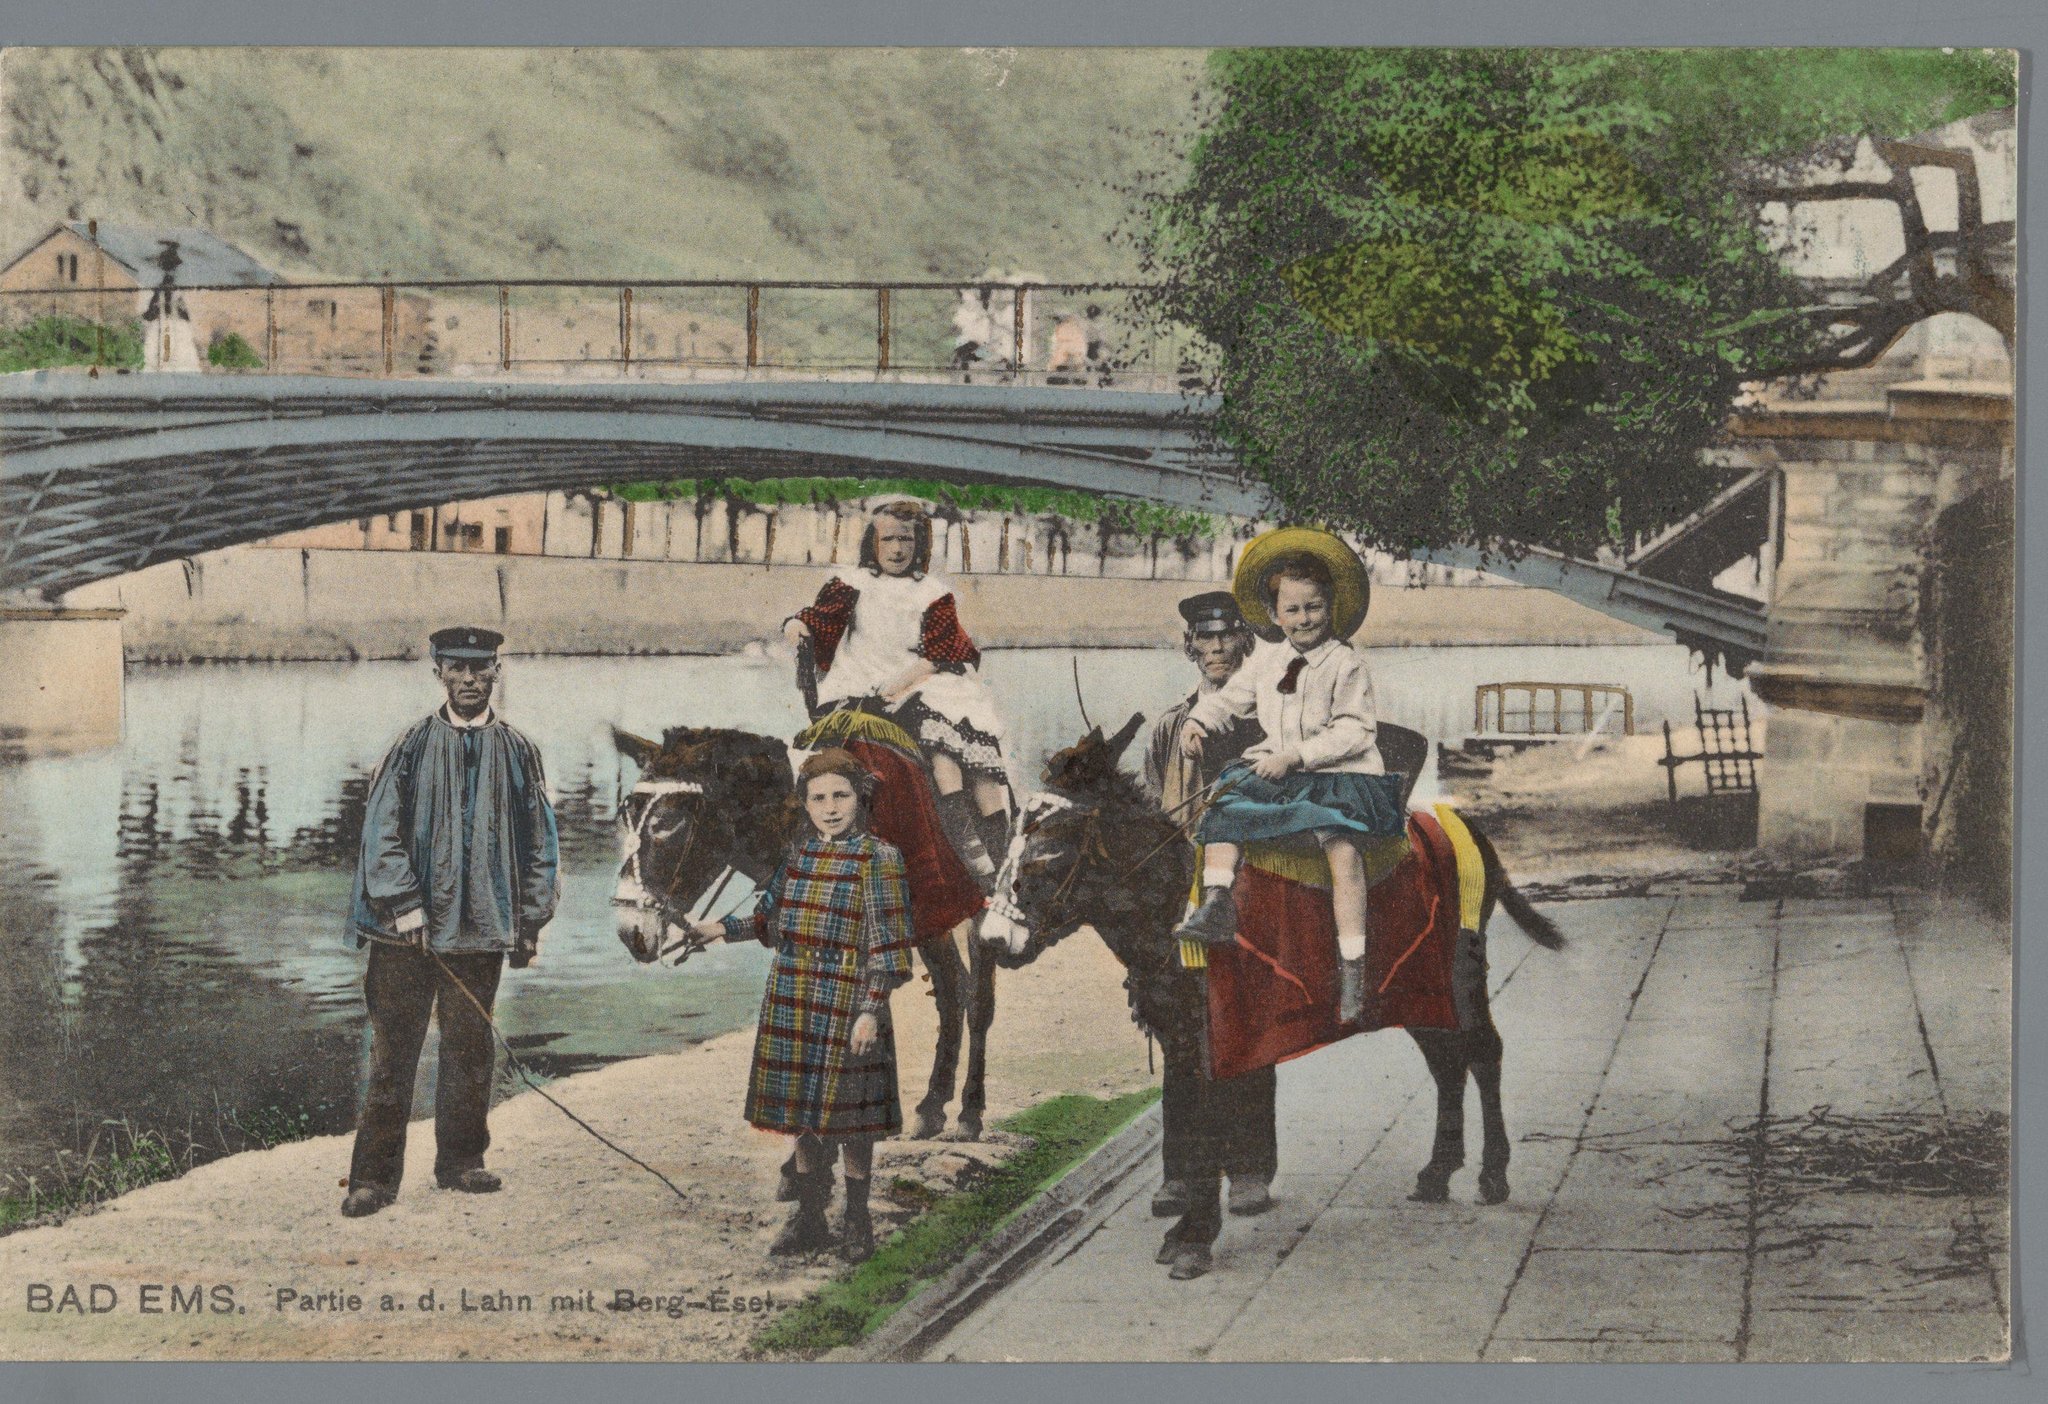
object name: photomechanical print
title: Bad Ems. Partie a.d. Lahn mit Berg-Esel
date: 1910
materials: cardboard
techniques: photograph, hand coloring, writing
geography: bad ems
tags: ass, donkey, child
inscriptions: number: ‘5529’